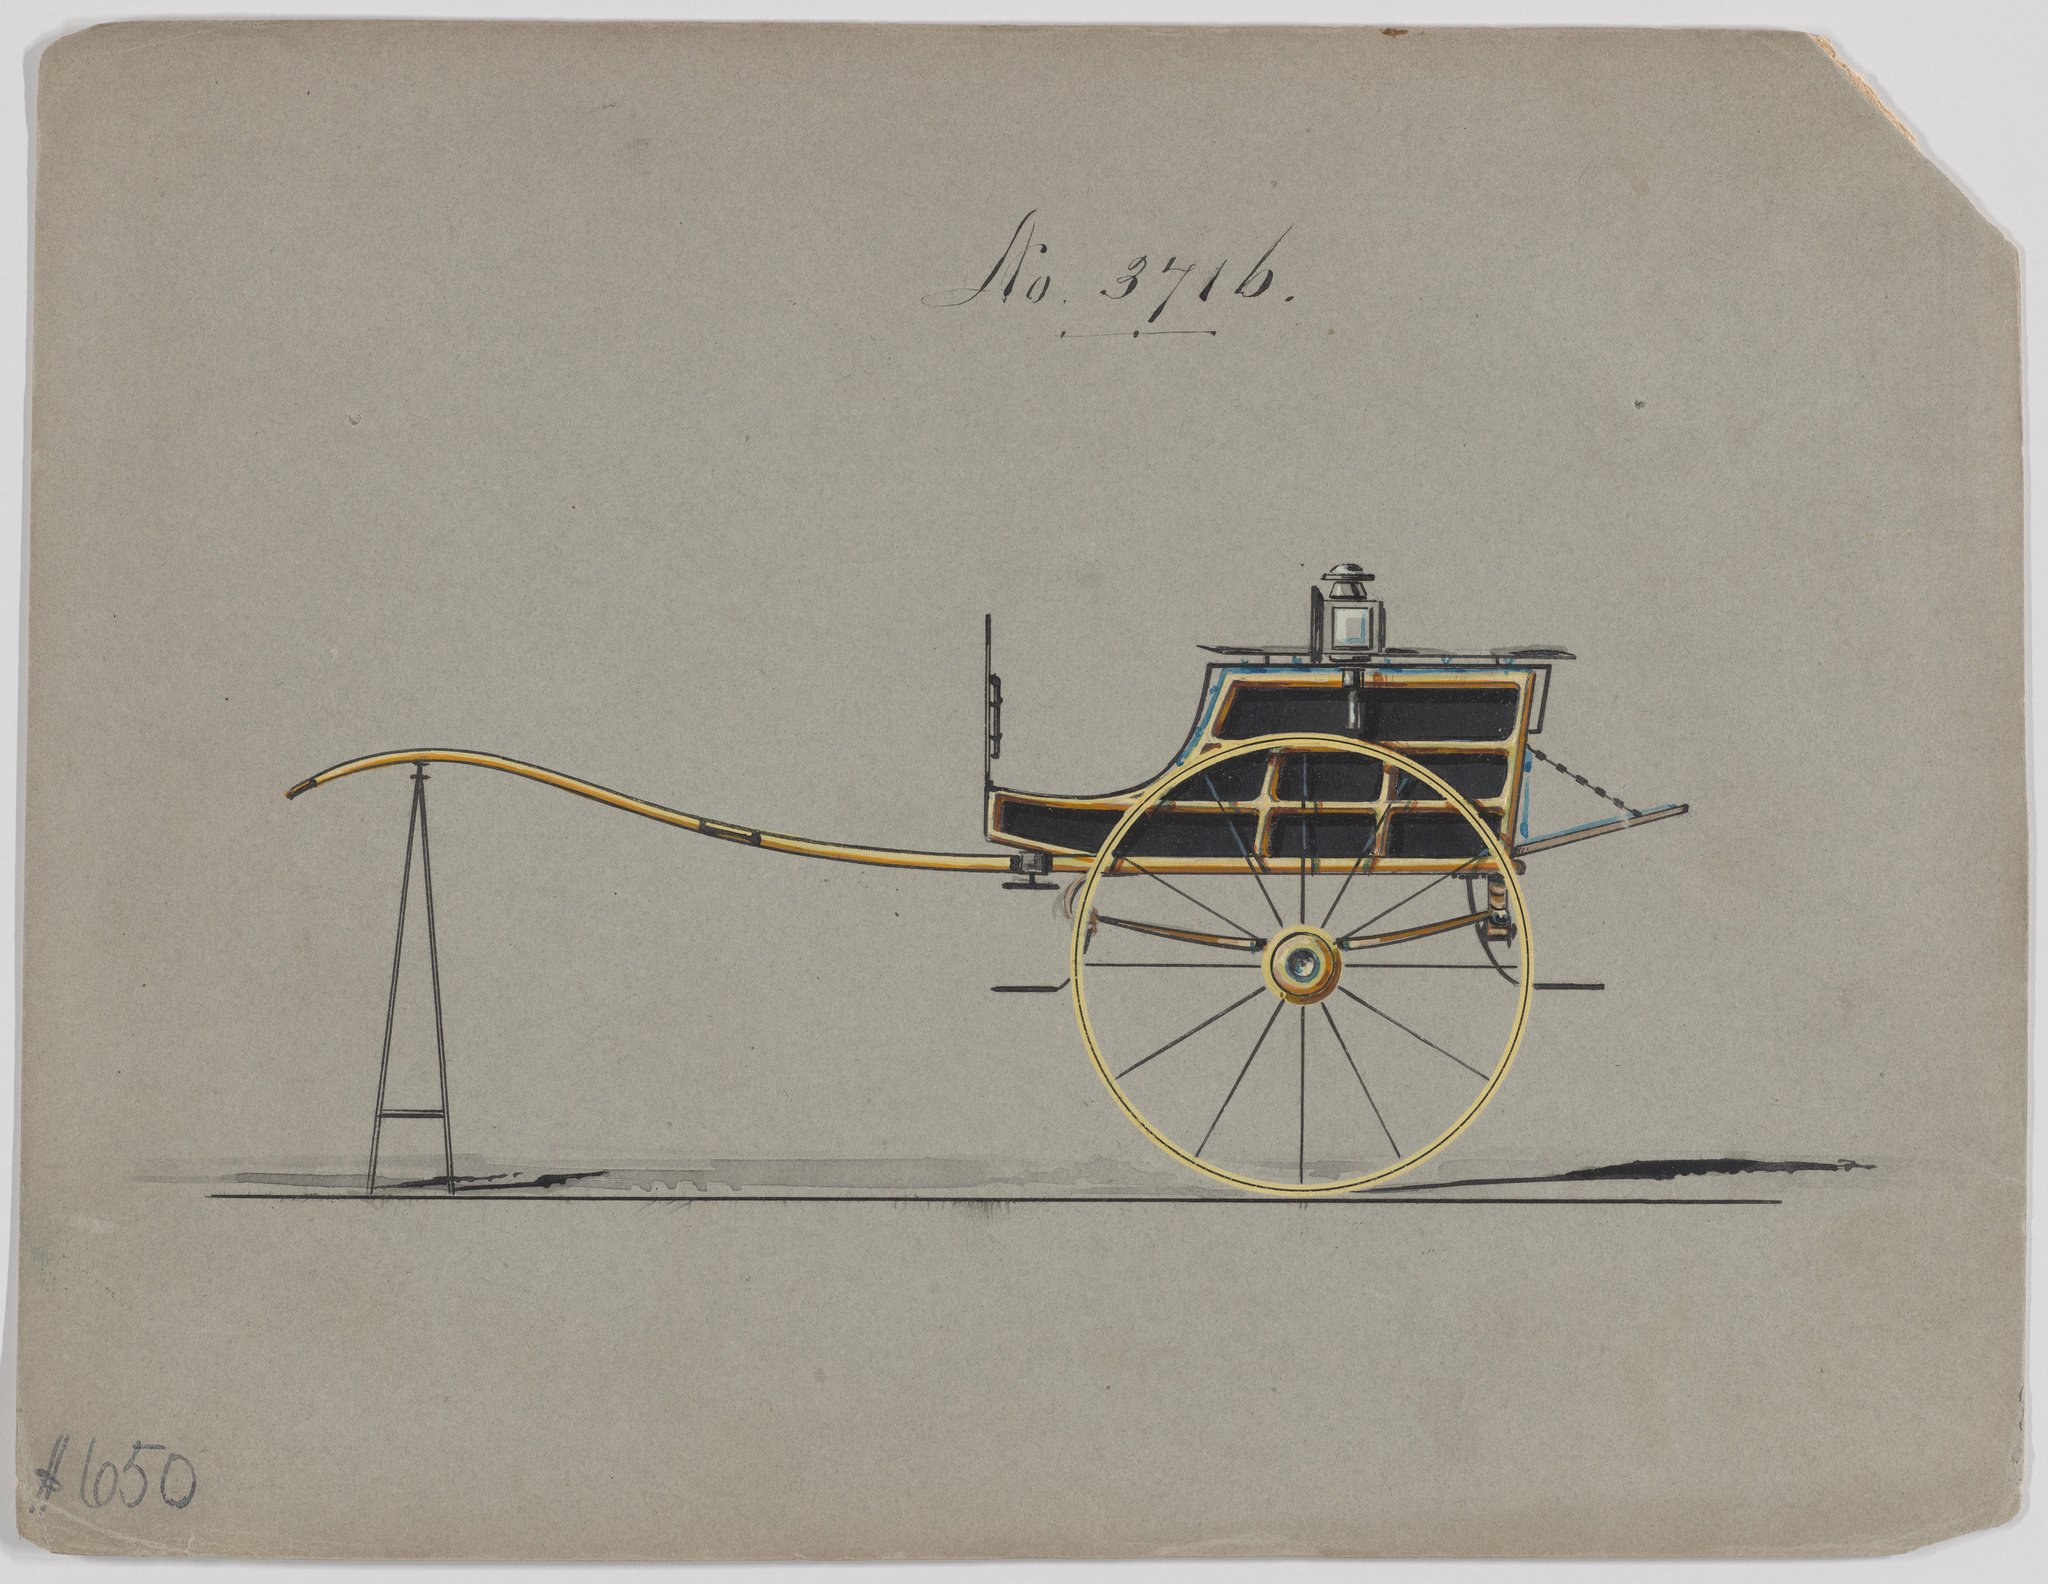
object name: drawing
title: Cart #3716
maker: brewster & co.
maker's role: manufacturer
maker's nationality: american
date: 1881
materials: gouache, gum arabic, watercolor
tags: carriages